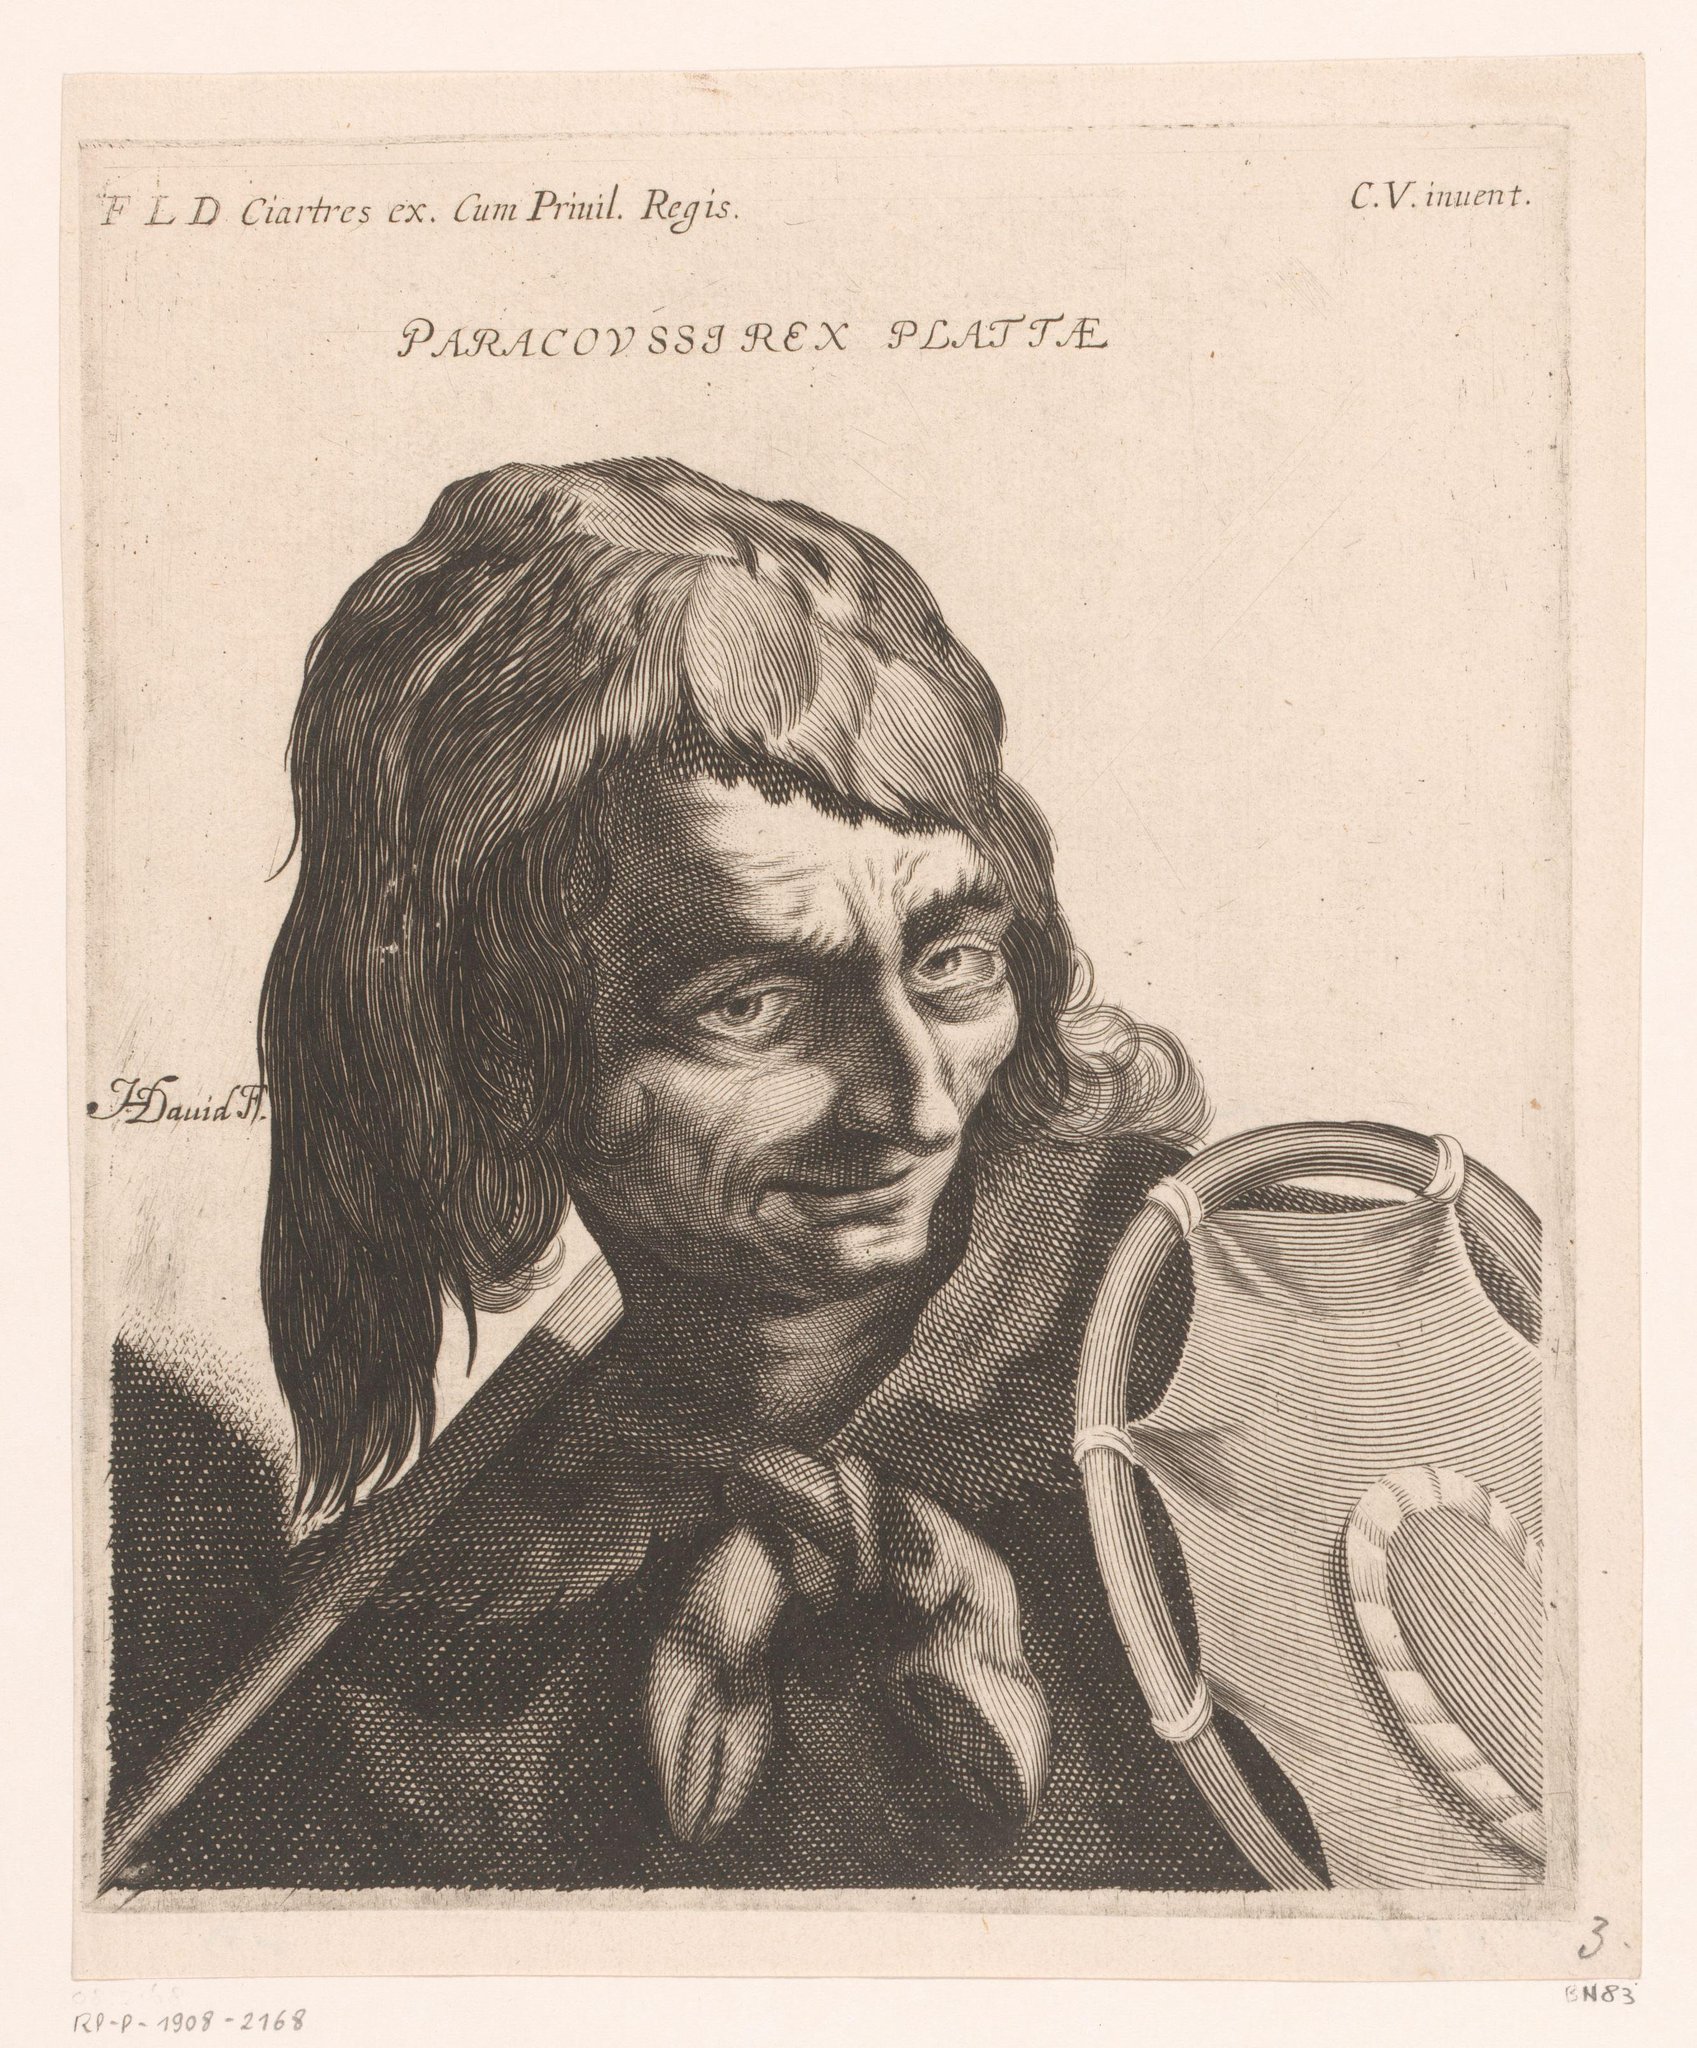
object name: print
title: Bustes van filosofen en koningen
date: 1615-1647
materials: paper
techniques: engraving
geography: paris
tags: historical persons, ruler, sovereign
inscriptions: collector's mark: Lugt 2228